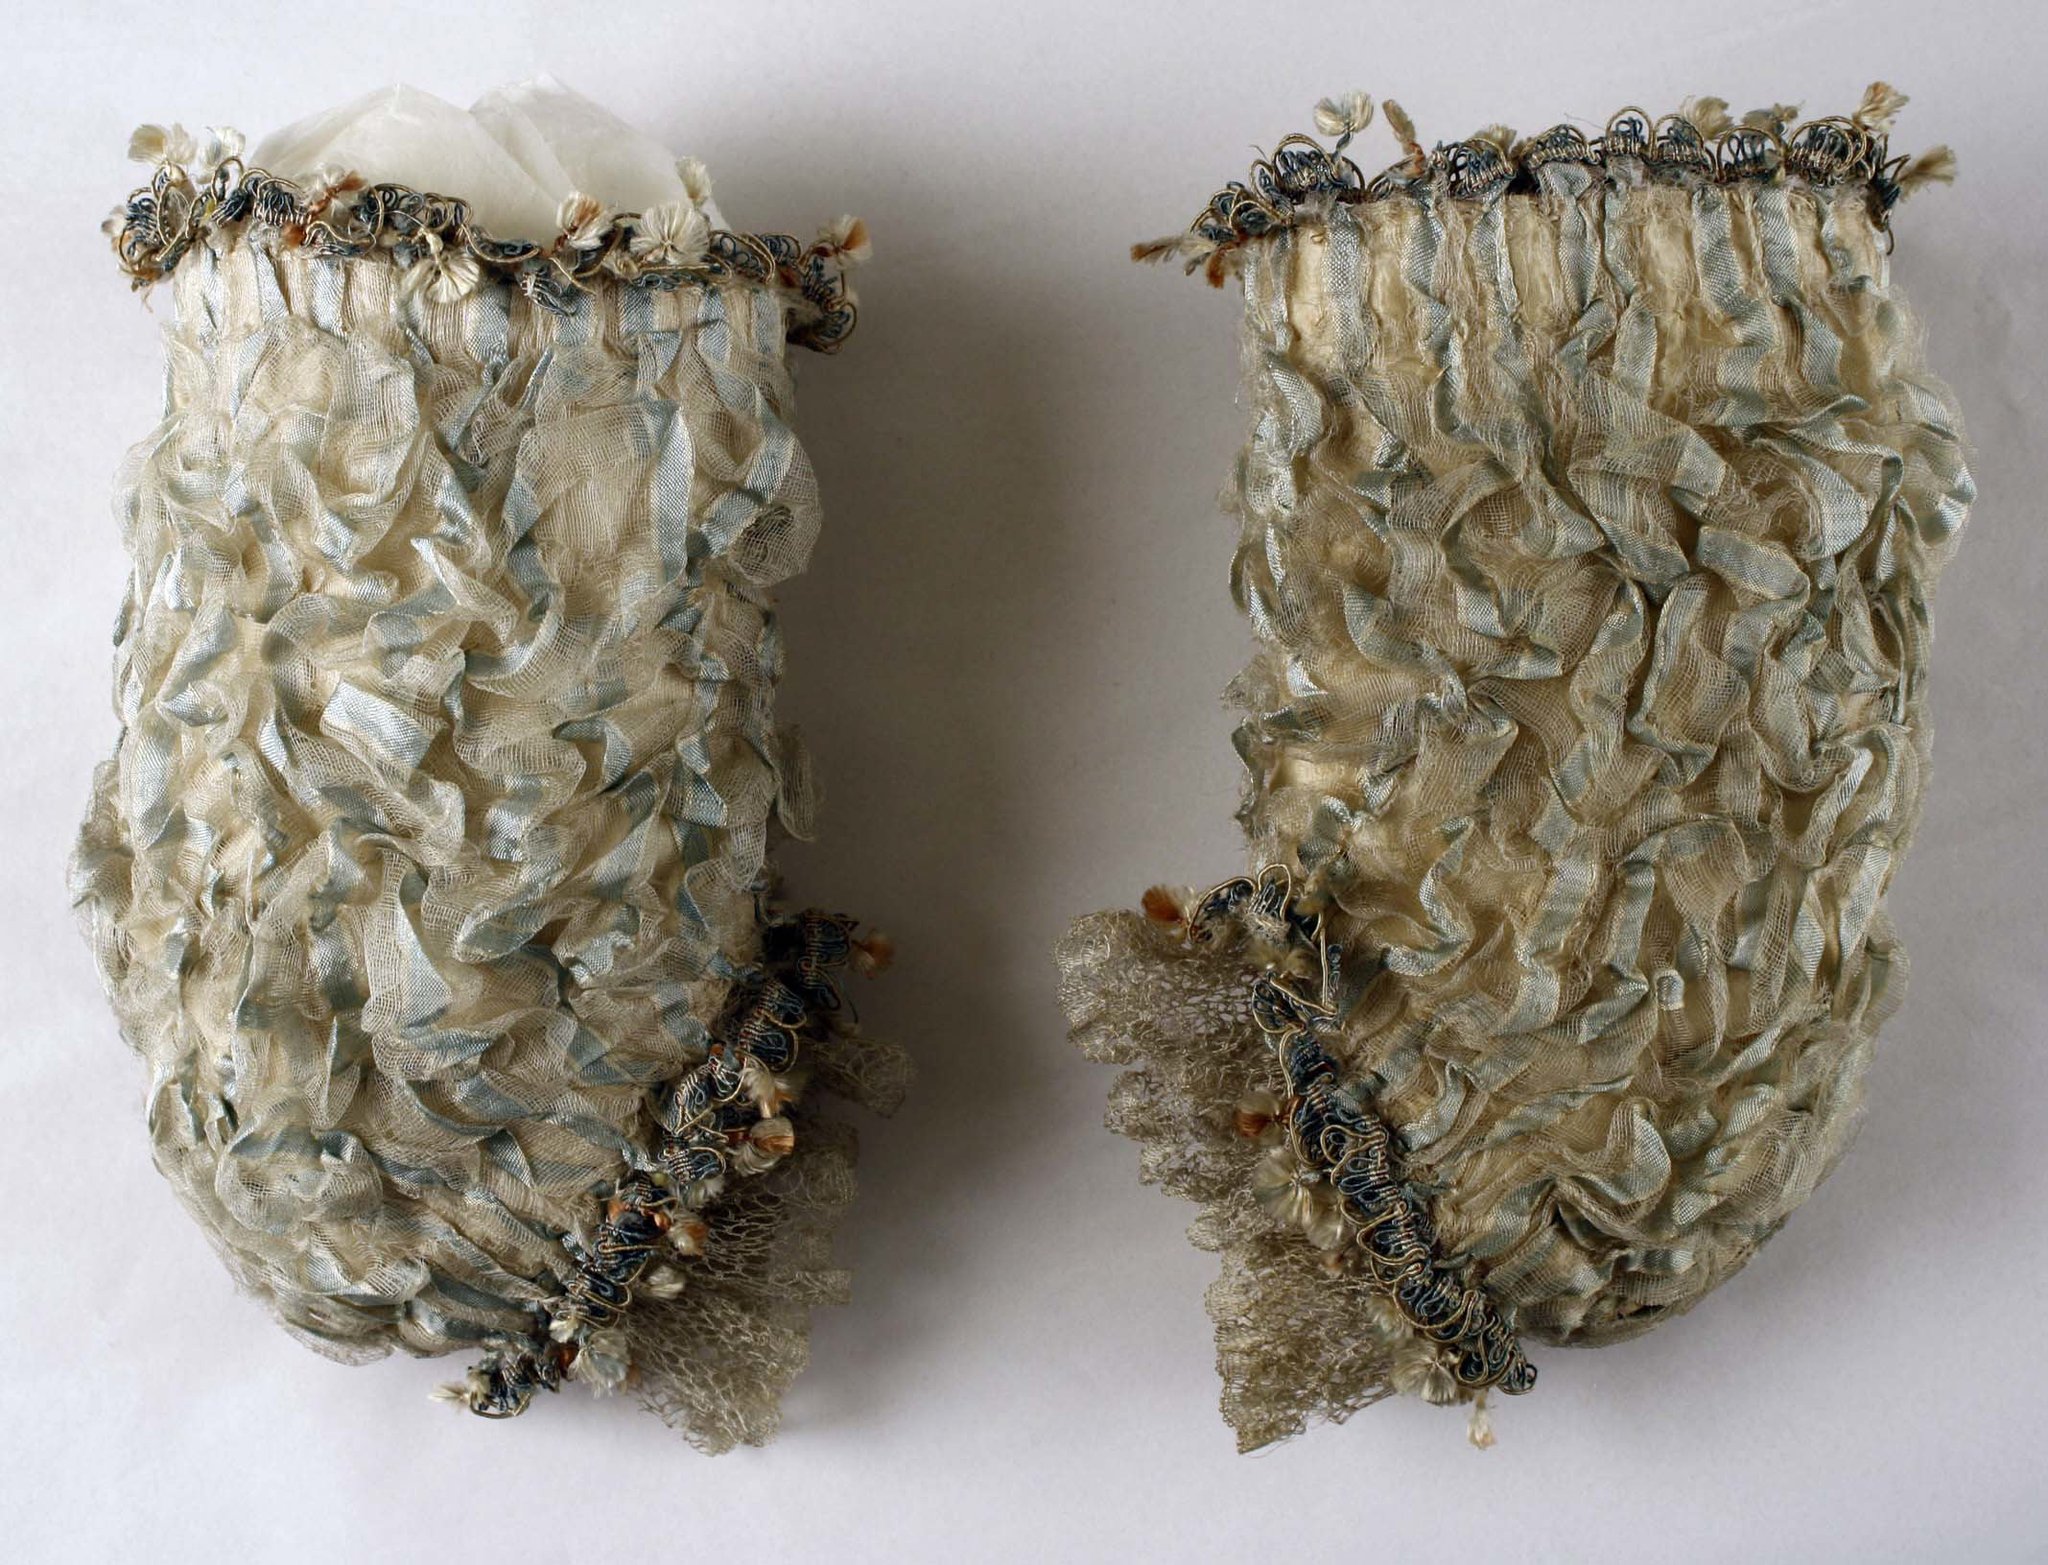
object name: cuff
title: Cuffs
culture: french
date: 1770-1779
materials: silk